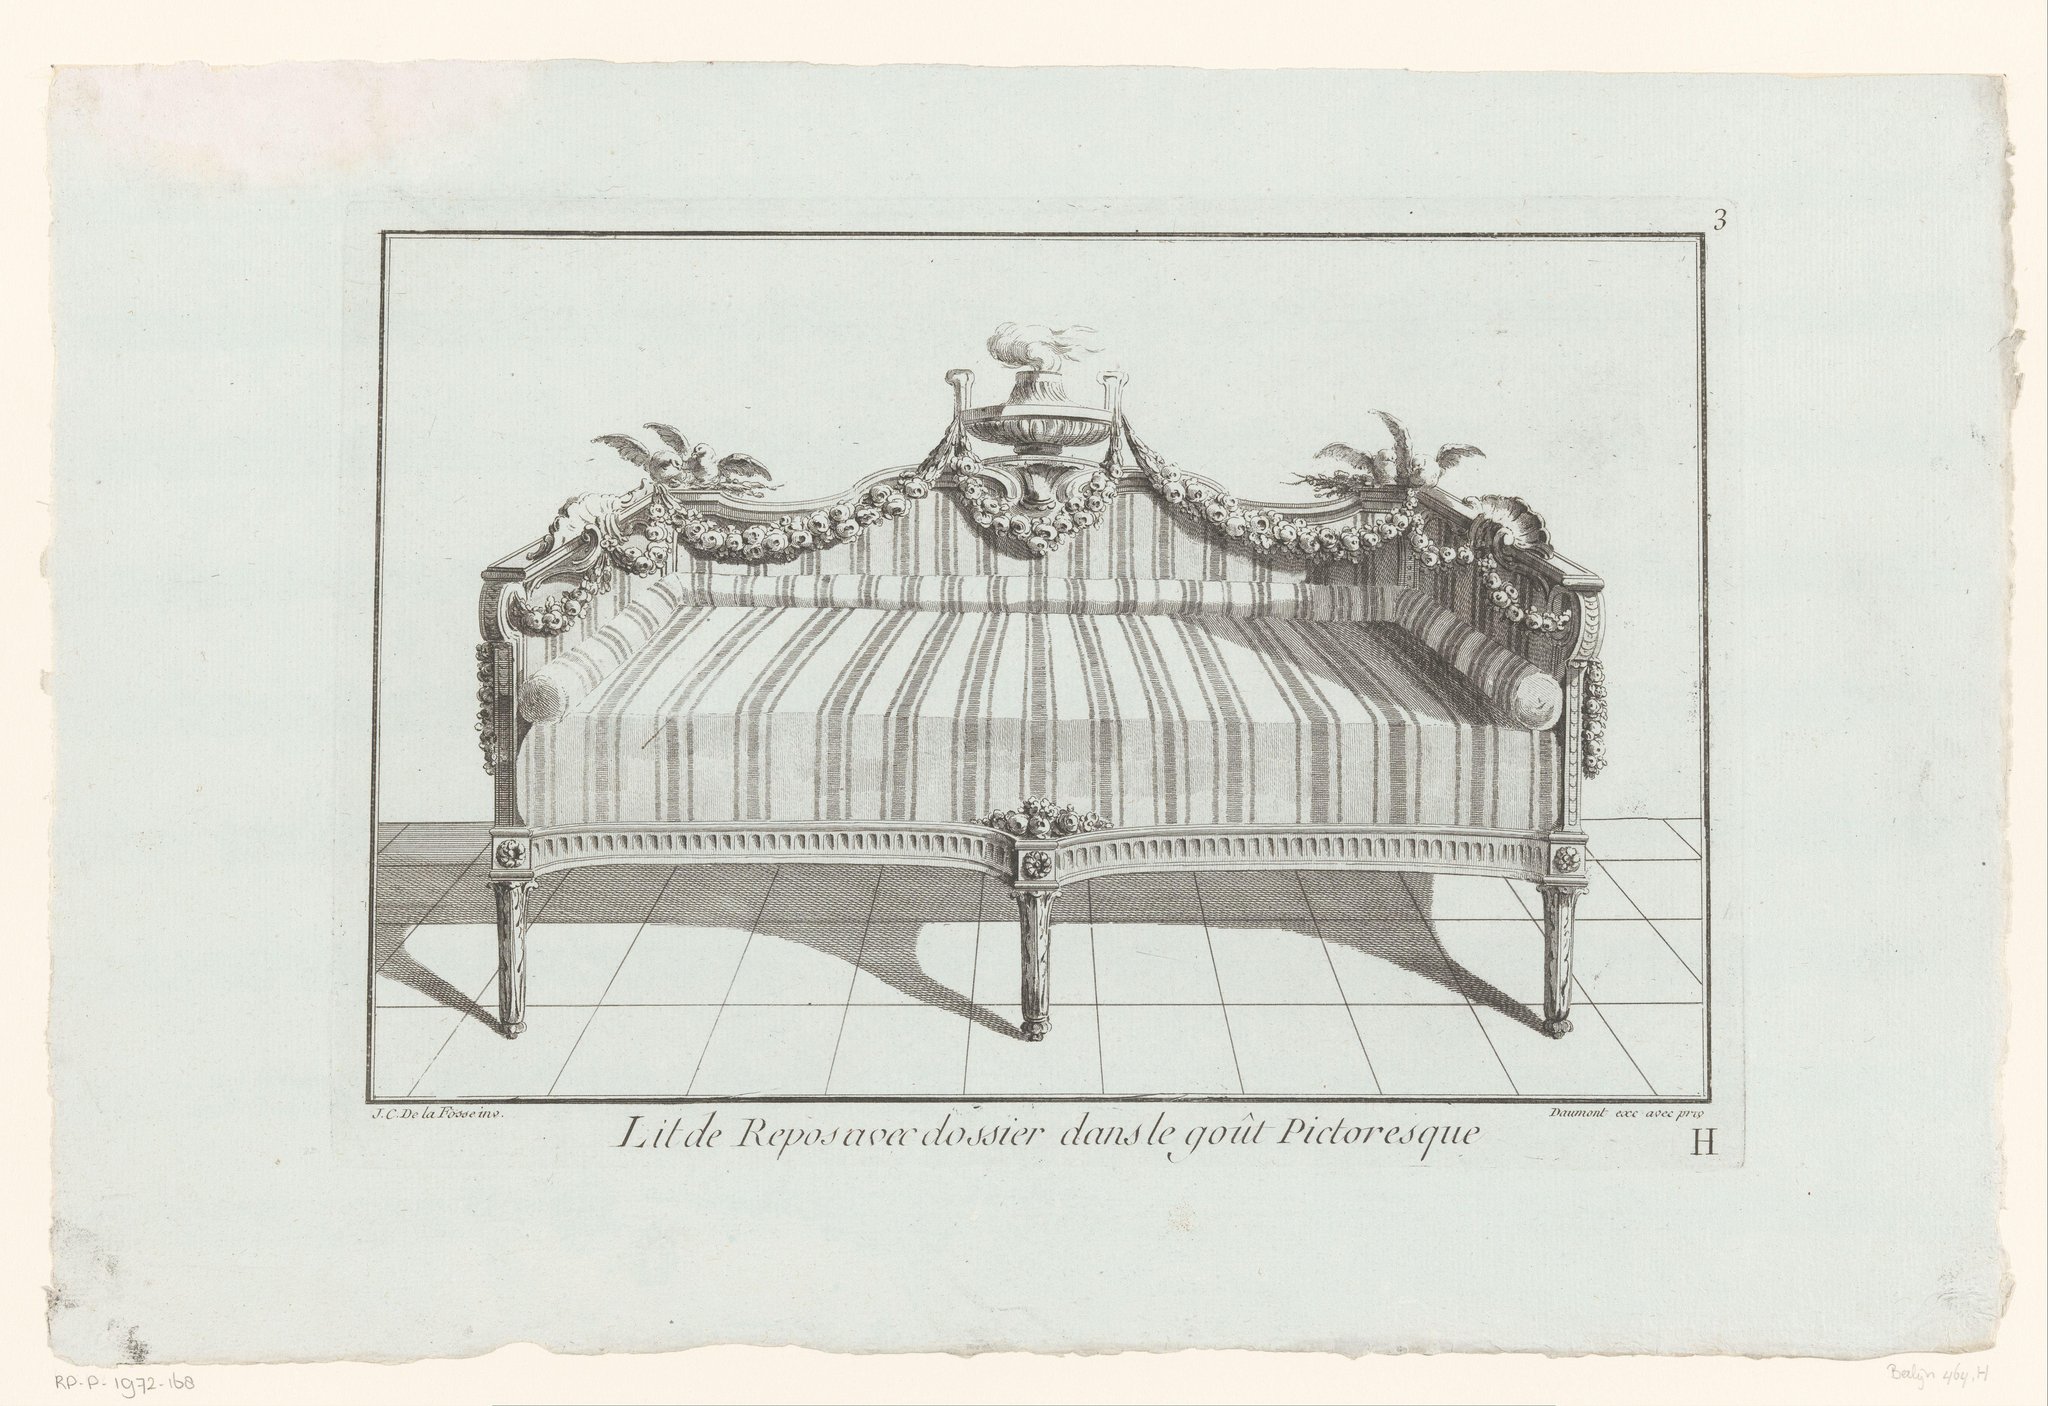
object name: print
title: Lit de Repos avec dossier dans le goût Pictoresque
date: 1745-1775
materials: paper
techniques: engraving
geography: paris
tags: bed, incense-burner ~ scents, perfumes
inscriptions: collector's mark: Lugt 2760, collector's mark: Lugt 2228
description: Een bed met gestreepte bekleding en rolkussens, geornamenteerde met guirlandes, schelpmotieven, duiven en in het midden een rookvat.